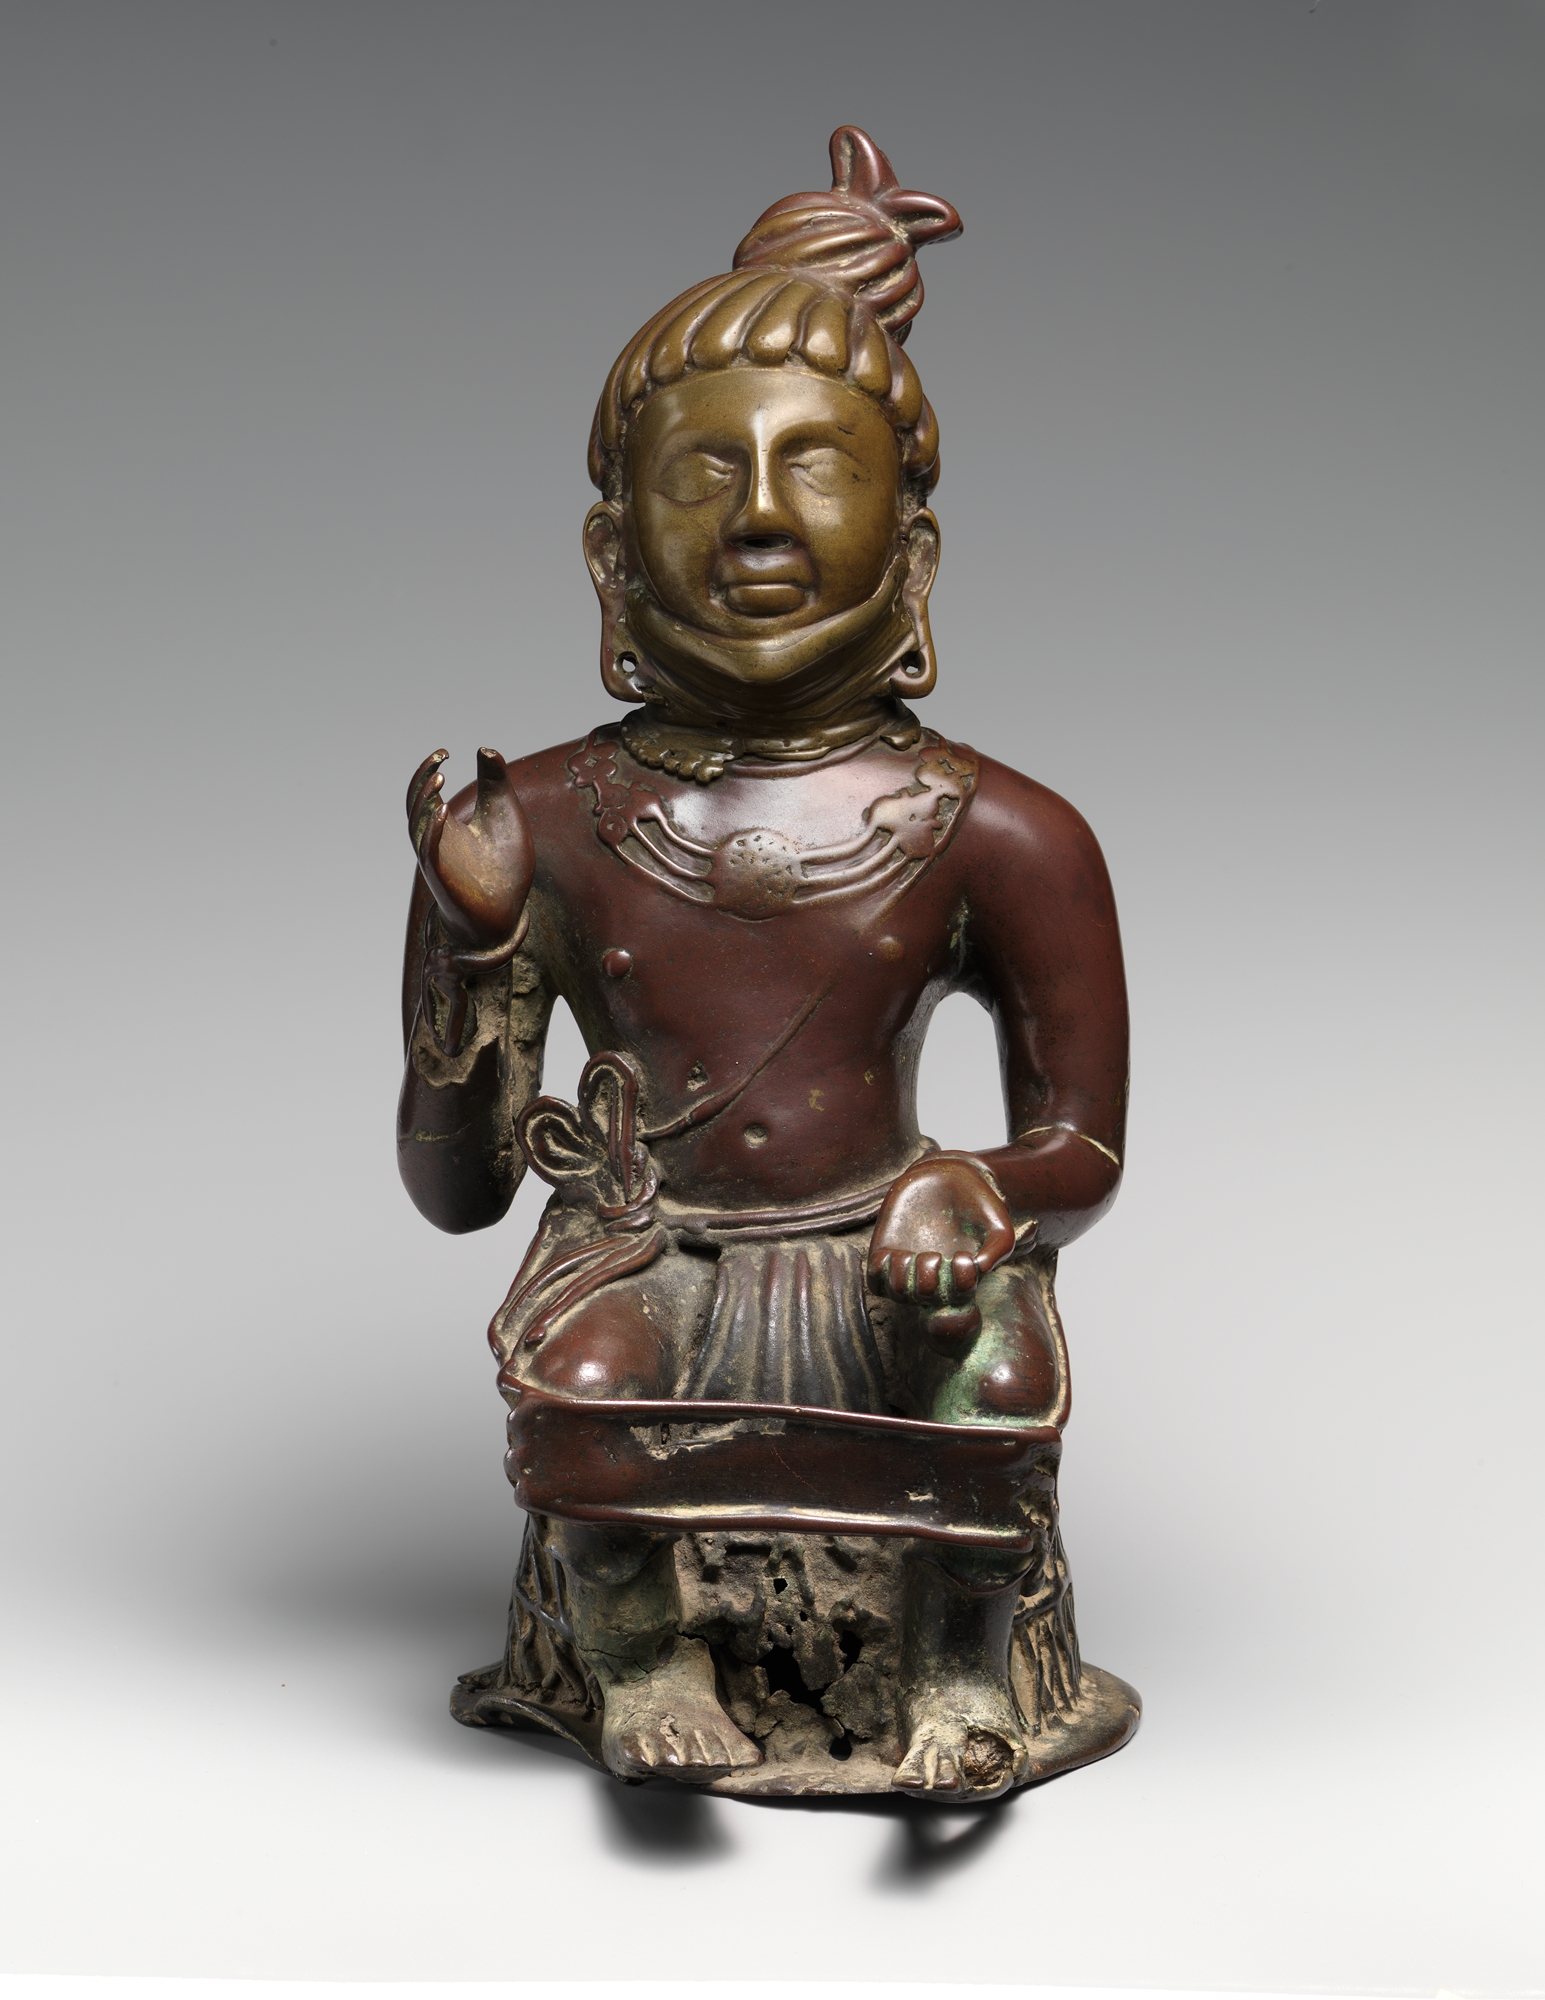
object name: figure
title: Seated Ascetic, Deified King, Agni (The God of Fire)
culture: indian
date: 201-300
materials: bronze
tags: gupta